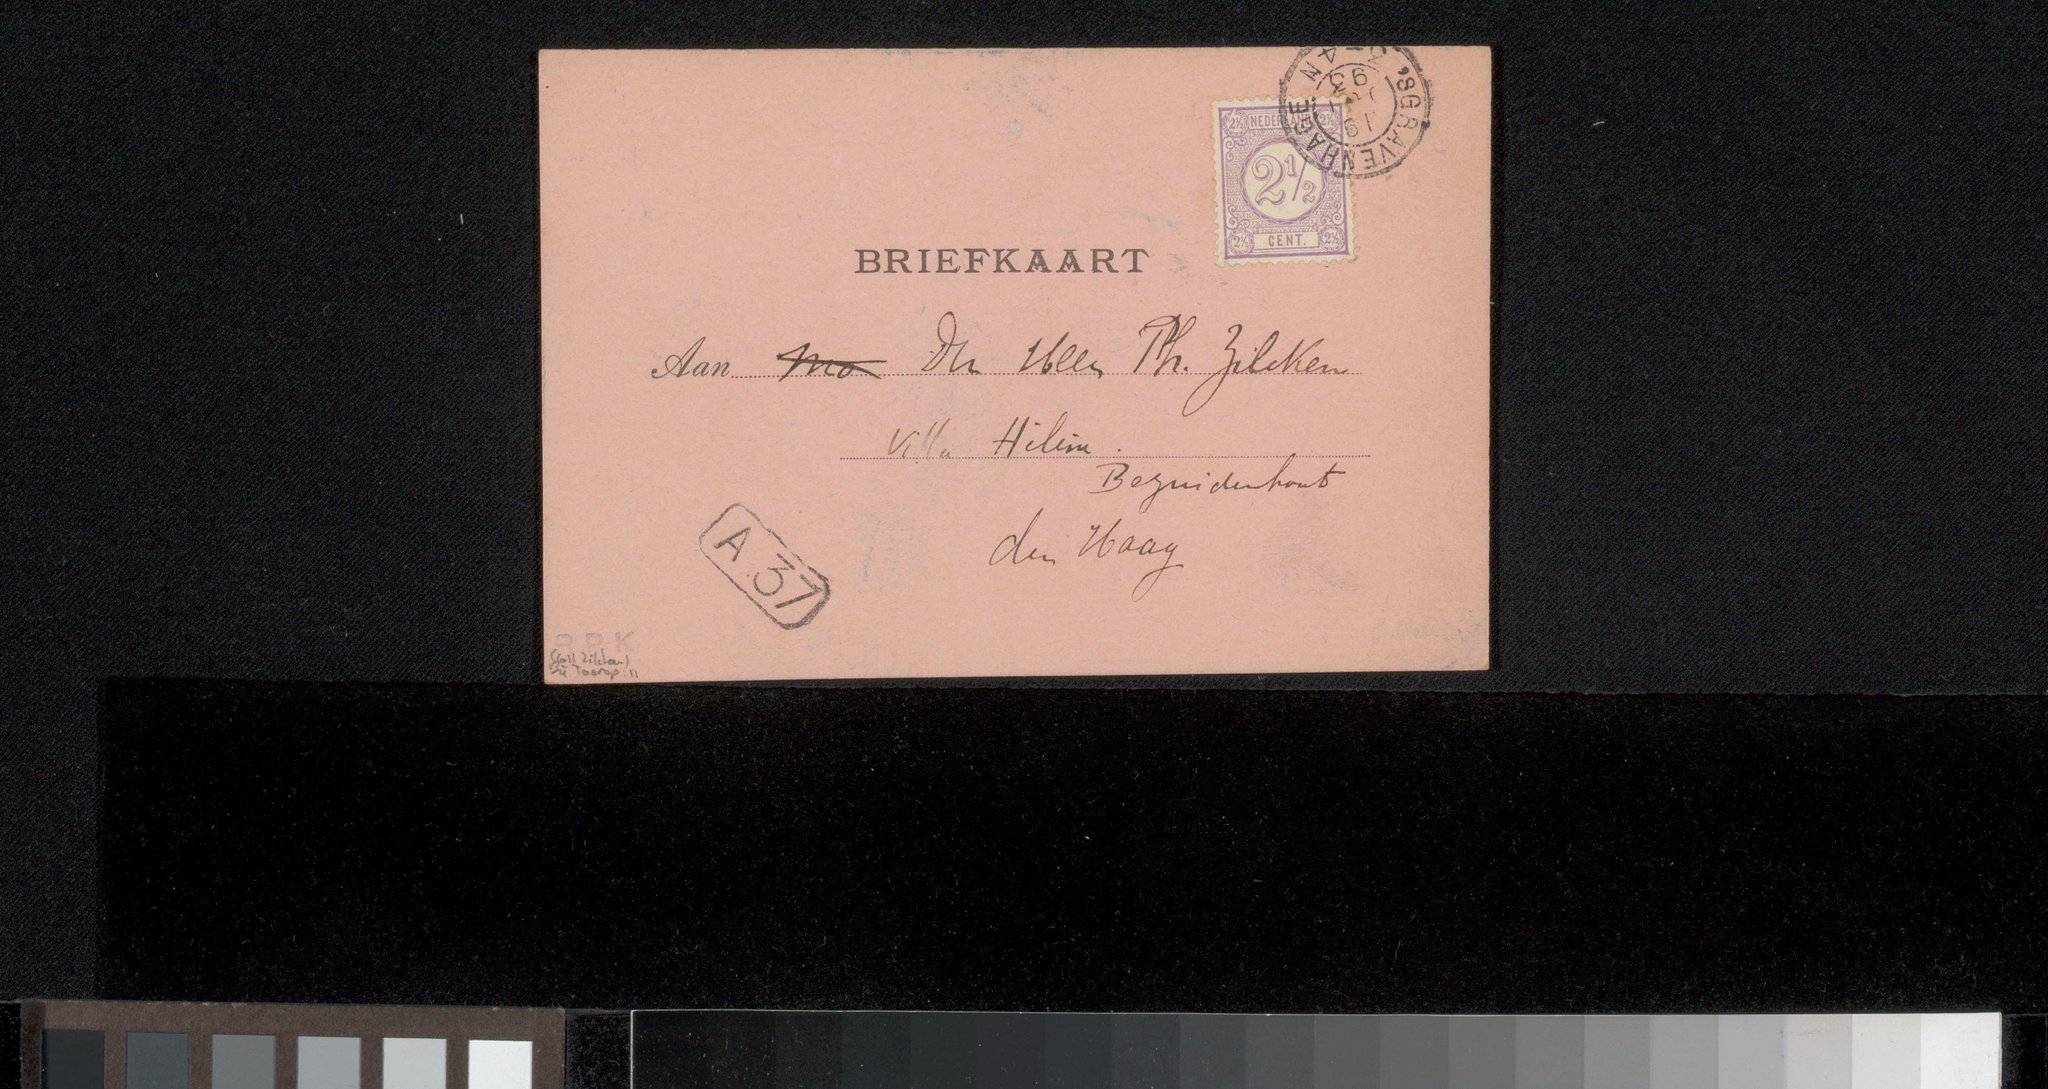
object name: postcard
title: Briefkaart aan Philip Zilcken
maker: jan toorop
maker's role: draughtsman, painter, print maker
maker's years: 1858-1928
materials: cardboard, ink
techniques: pen, writing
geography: the hague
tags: the hague, painter, draughtsman, philip zilcken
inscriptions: collector's mark: ‘RPK’